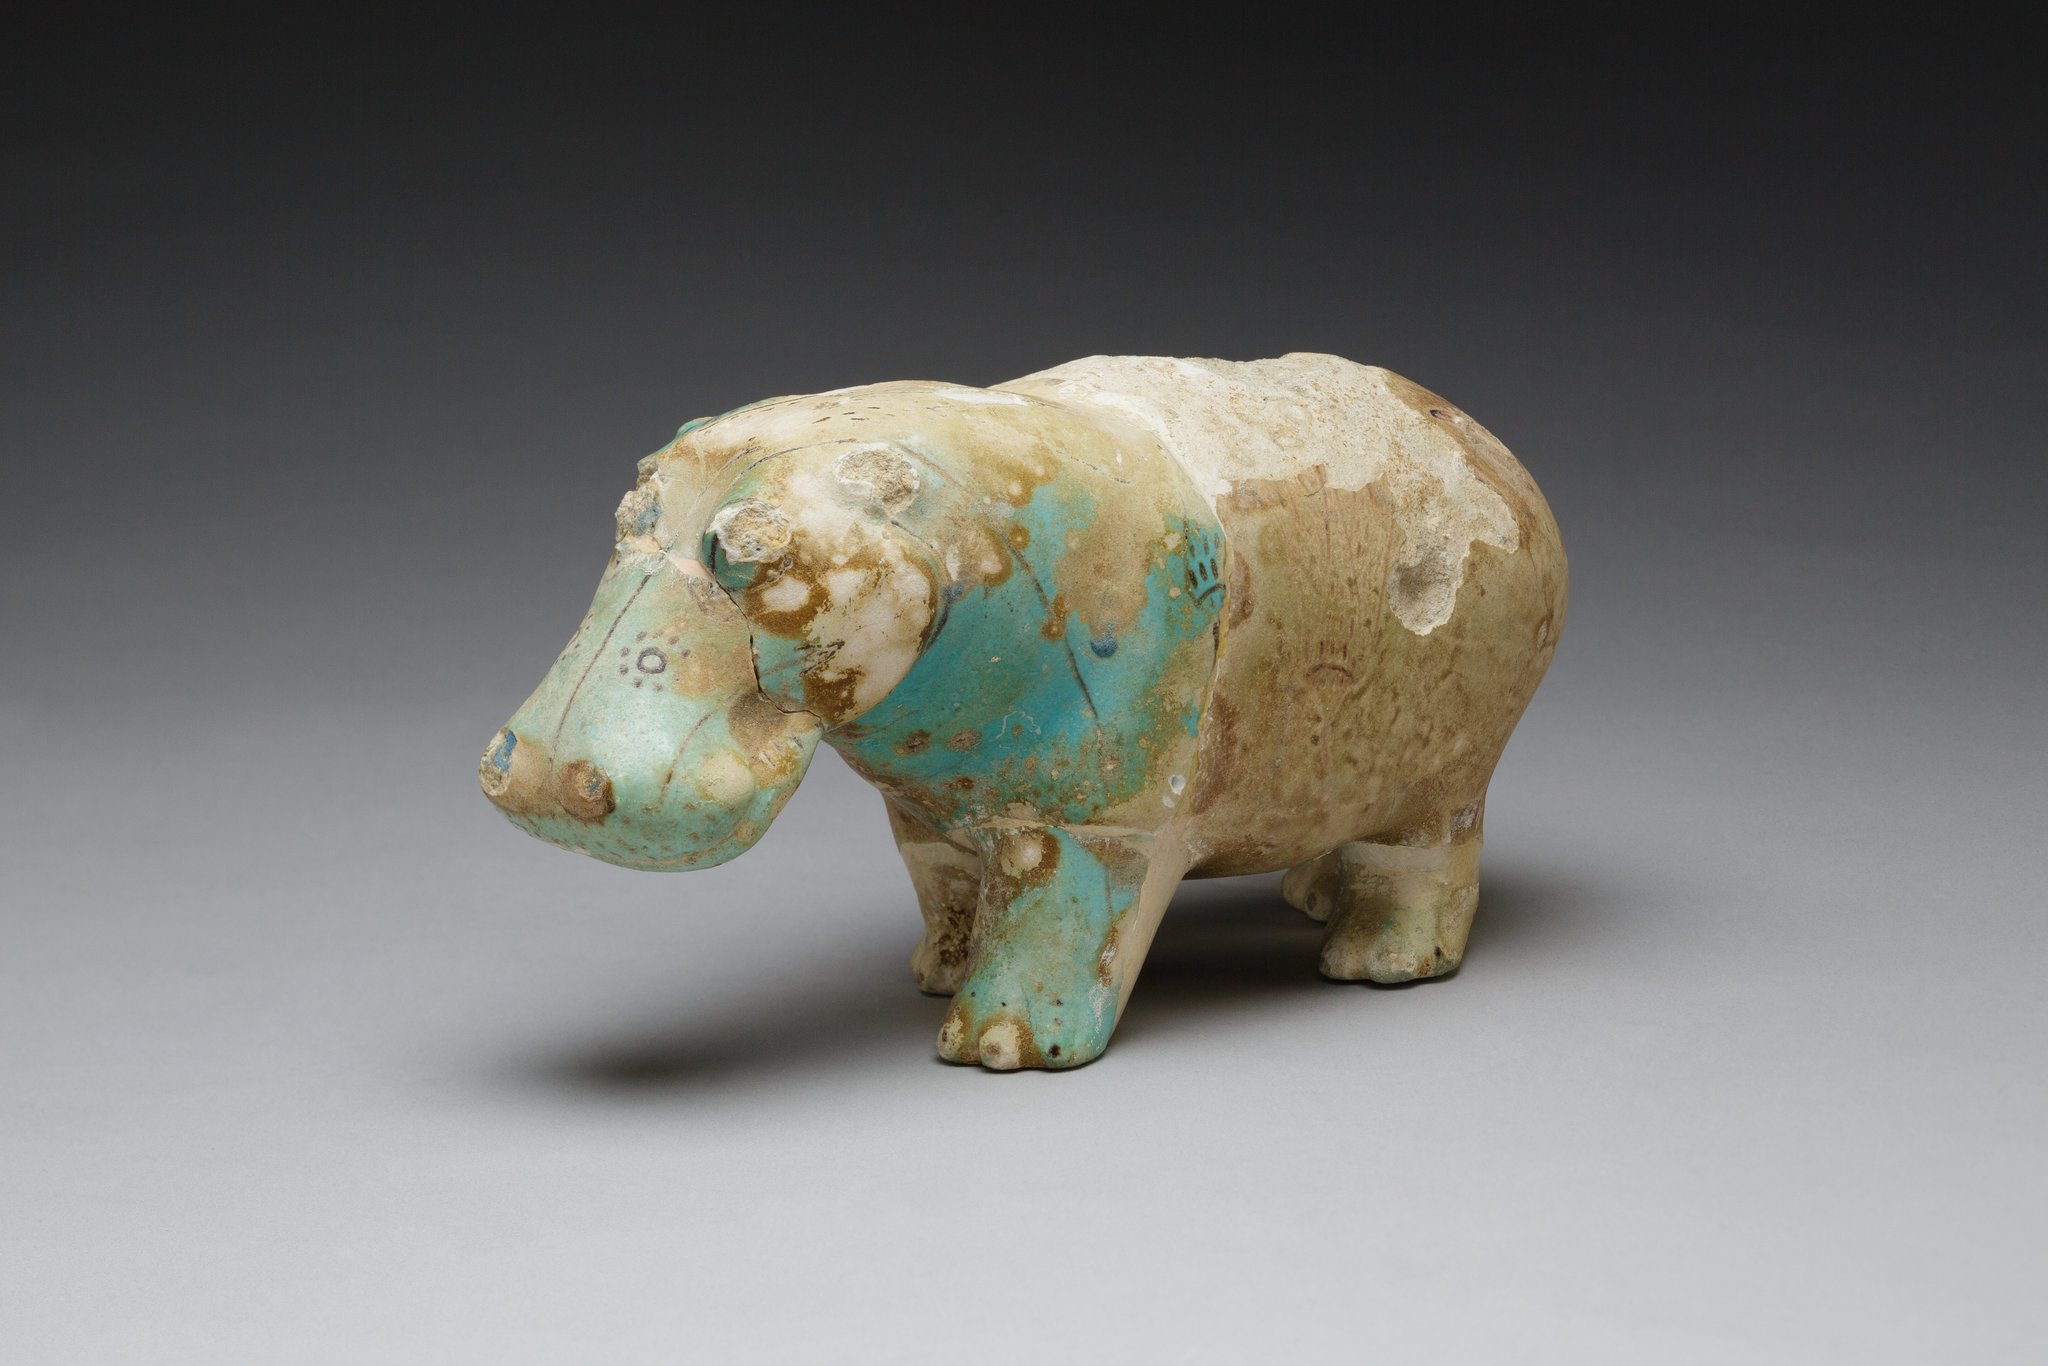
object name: figurine, hippopotamus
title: Hippopotamus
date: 1981-1650 BCE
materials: faience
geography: egypt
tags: hippos